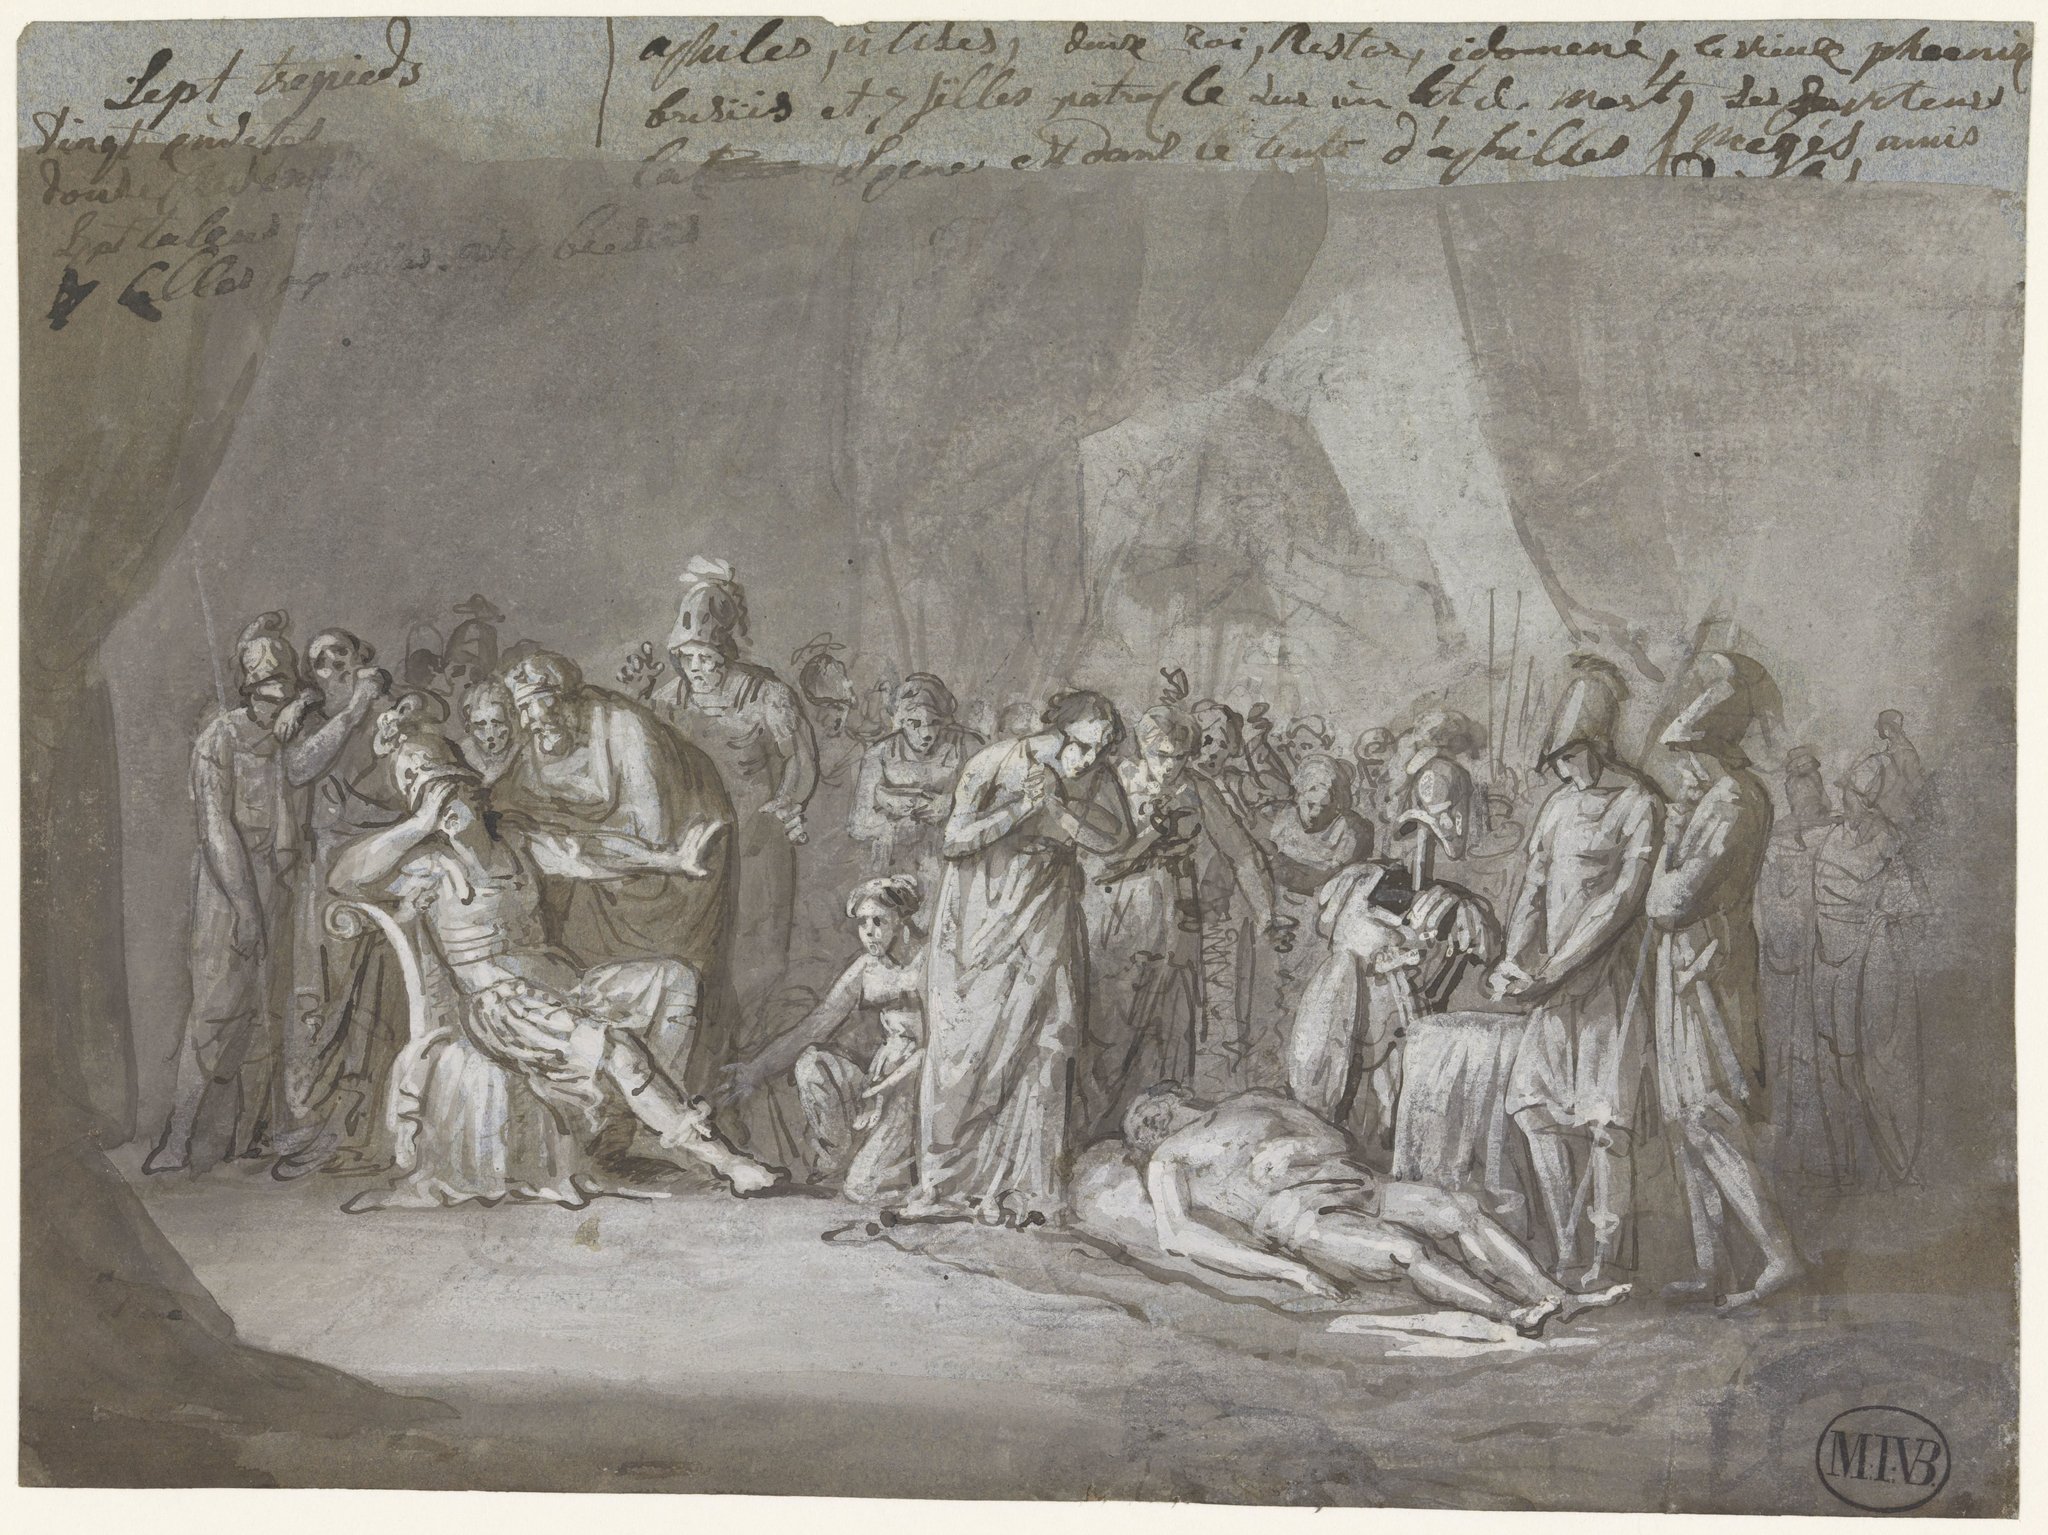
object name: drawing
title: Het lijk van Patroclus in Achilles tent beweend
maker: mattheus ignatius van bree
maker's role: draughtsman, print maker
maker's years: 1773-1839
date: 1783-1839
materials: paint, ink, paper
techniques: brush, pen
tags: achilles mourning over the body of patroclus